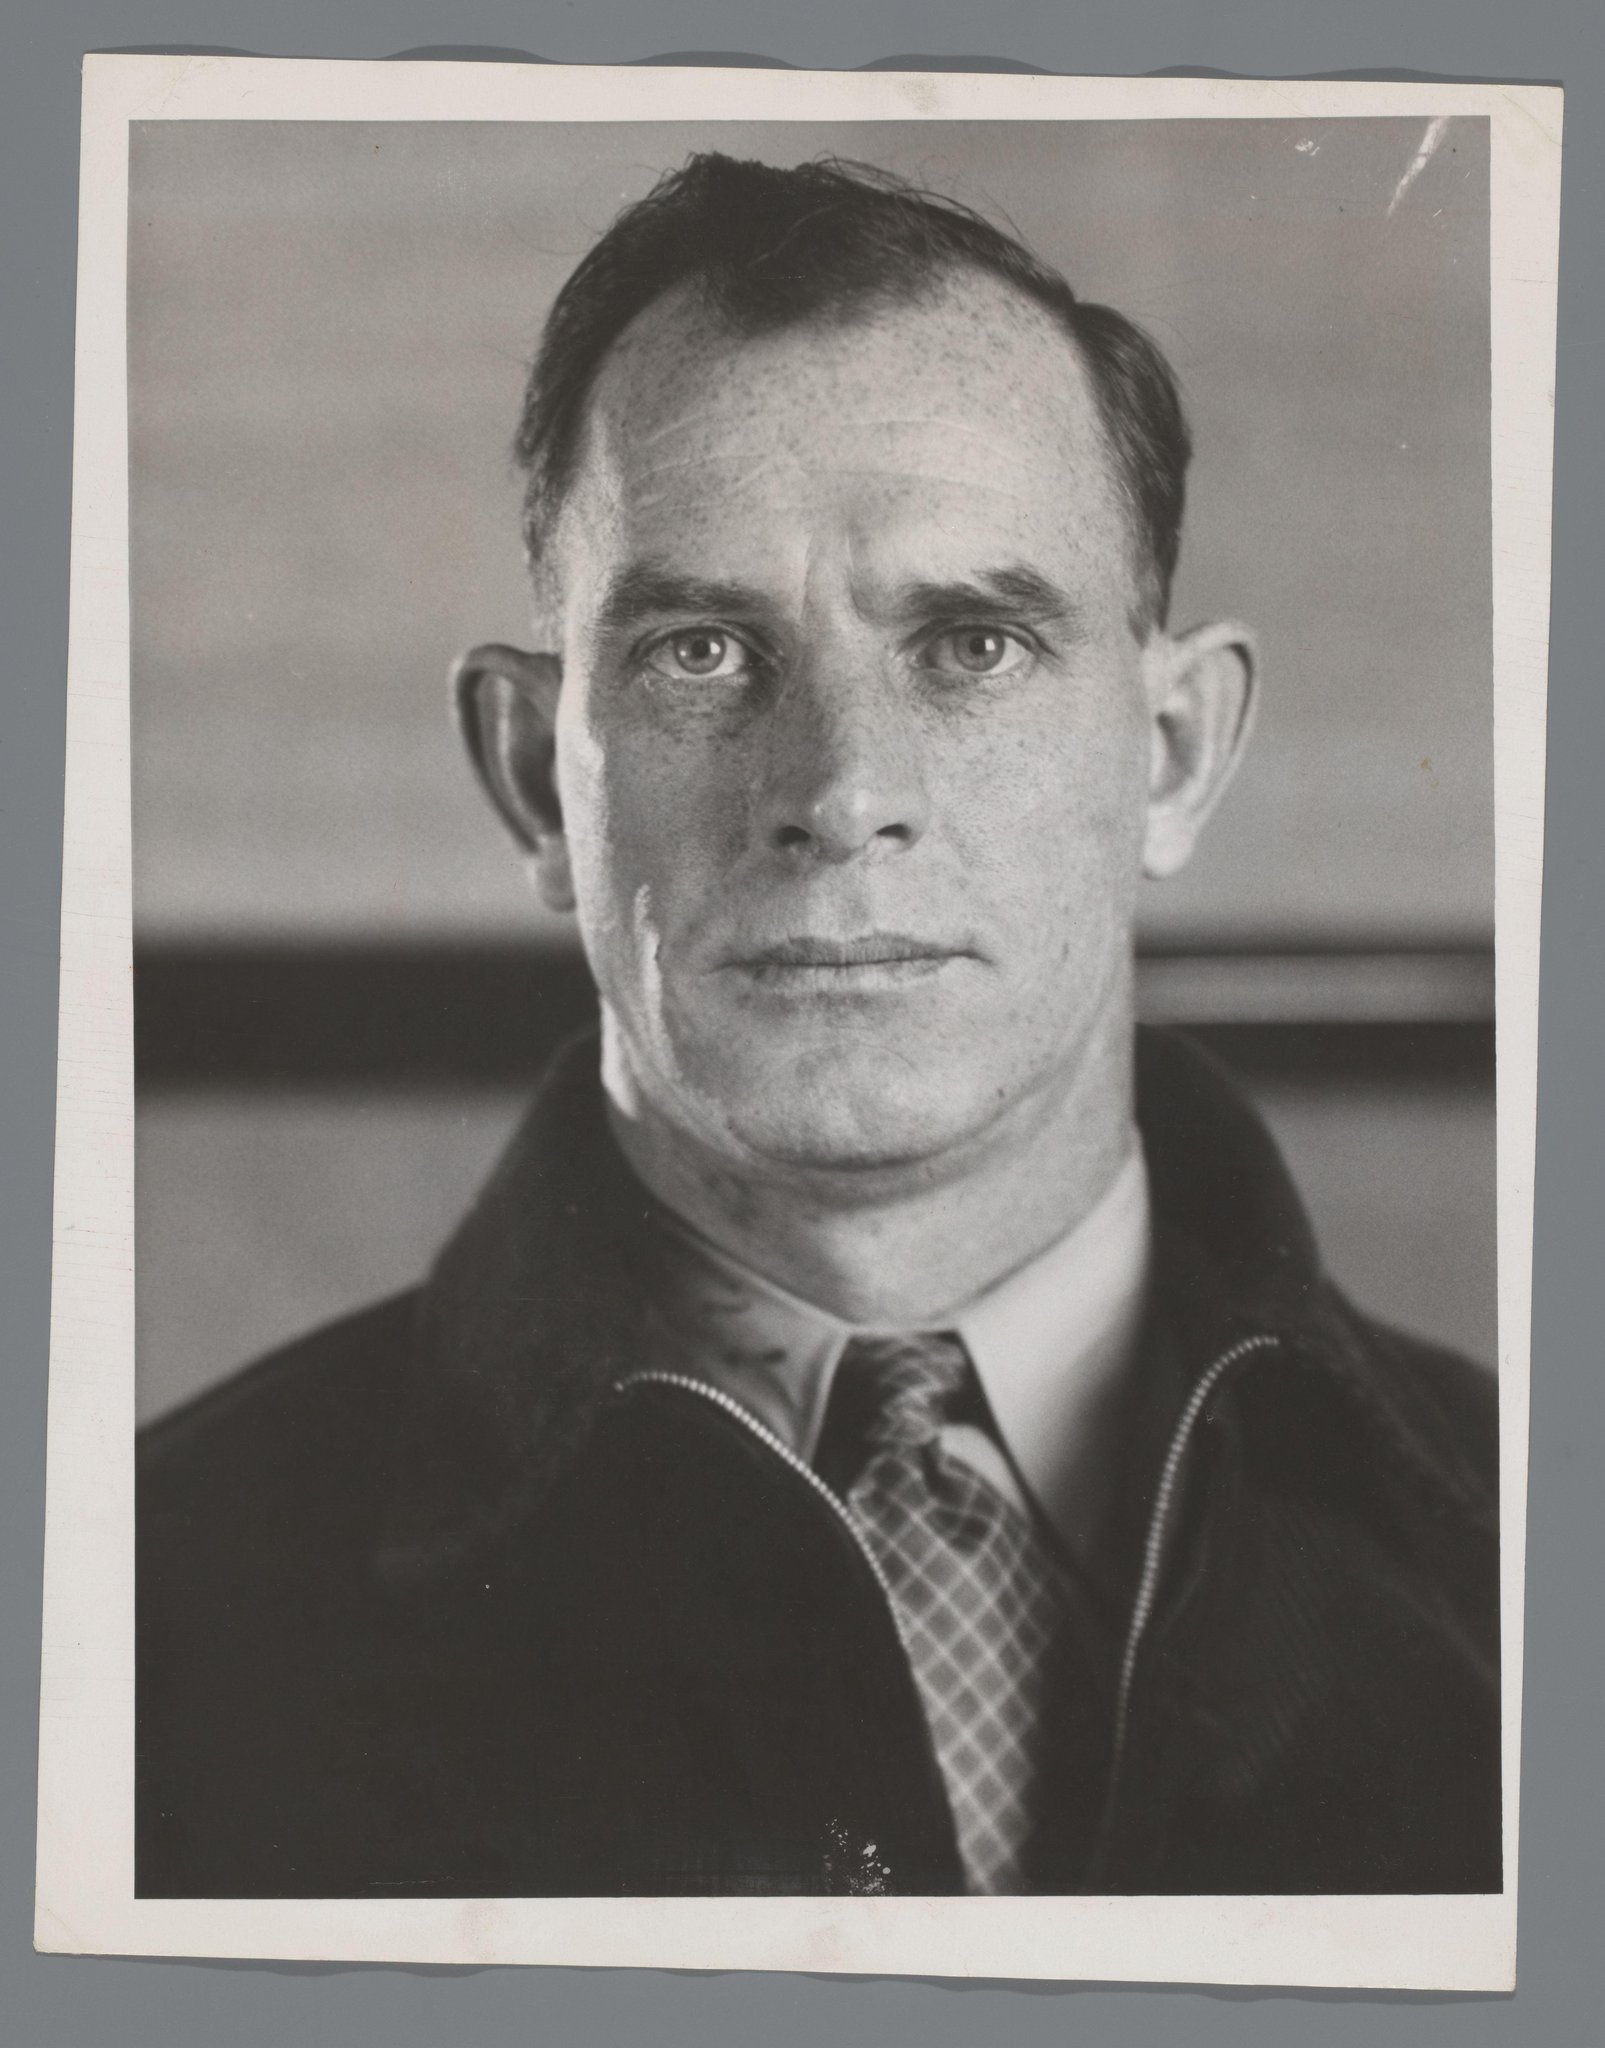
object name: photograph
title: Portret van Okey Odell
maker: Anonymous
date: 1934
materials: paper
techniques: gelatin silver print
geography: united states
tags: adult man, historical persons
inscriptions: inscription: ‘REFERENCE DEPT./ APR 27 1935/ PRESS’, number: ‘174452’, inscription: ‘1/2 vol home’, inscription: ‘Okey, Odell, militant leader of Hardin County Union/ Workers, Otila, McGuffey, Ohio’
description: Okey Odell was stakingsleider in Hardon County, Ohio, die ontvoerd en mishandeld werd.